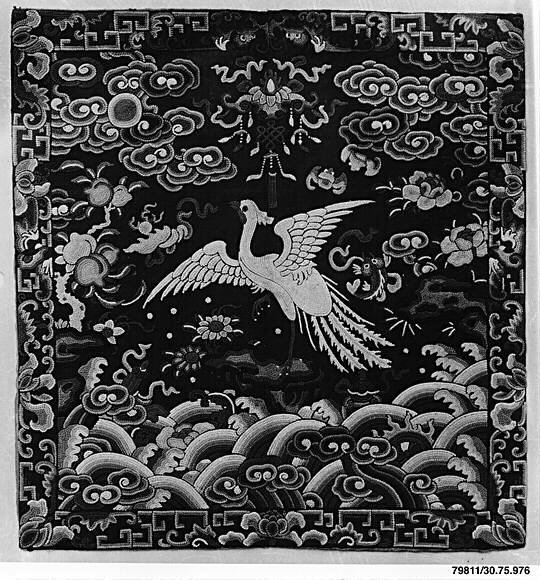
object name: rank badge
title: Rank Badge with Silver Pheasant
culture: chinese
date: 1767-1800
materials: silk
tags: bats,pheasants